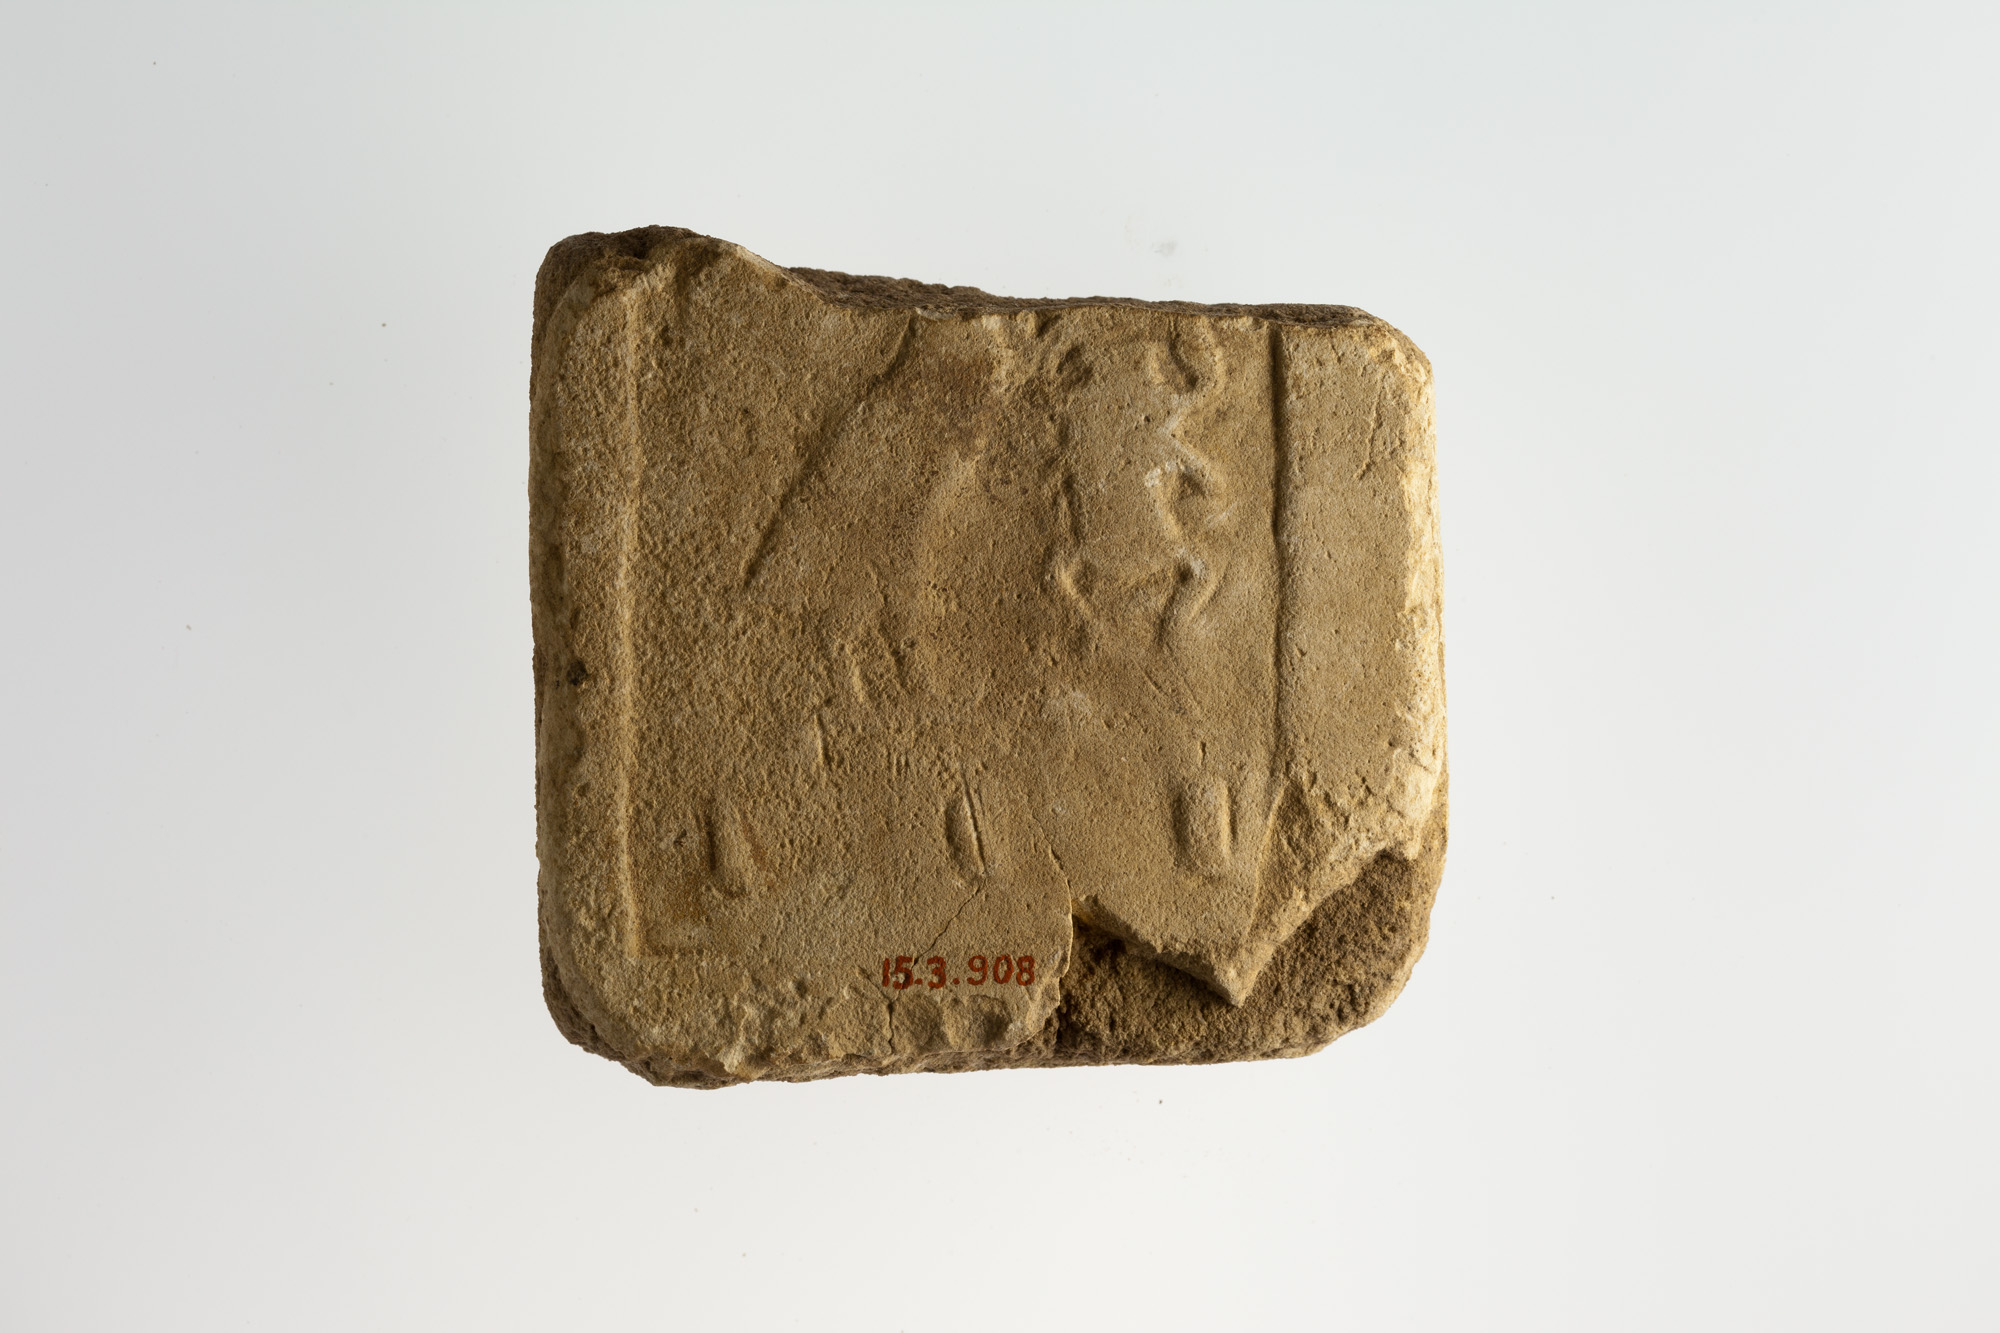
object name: fragment of a faience plaque with inscription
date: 1764-1759 BCE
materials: faience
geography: egypt